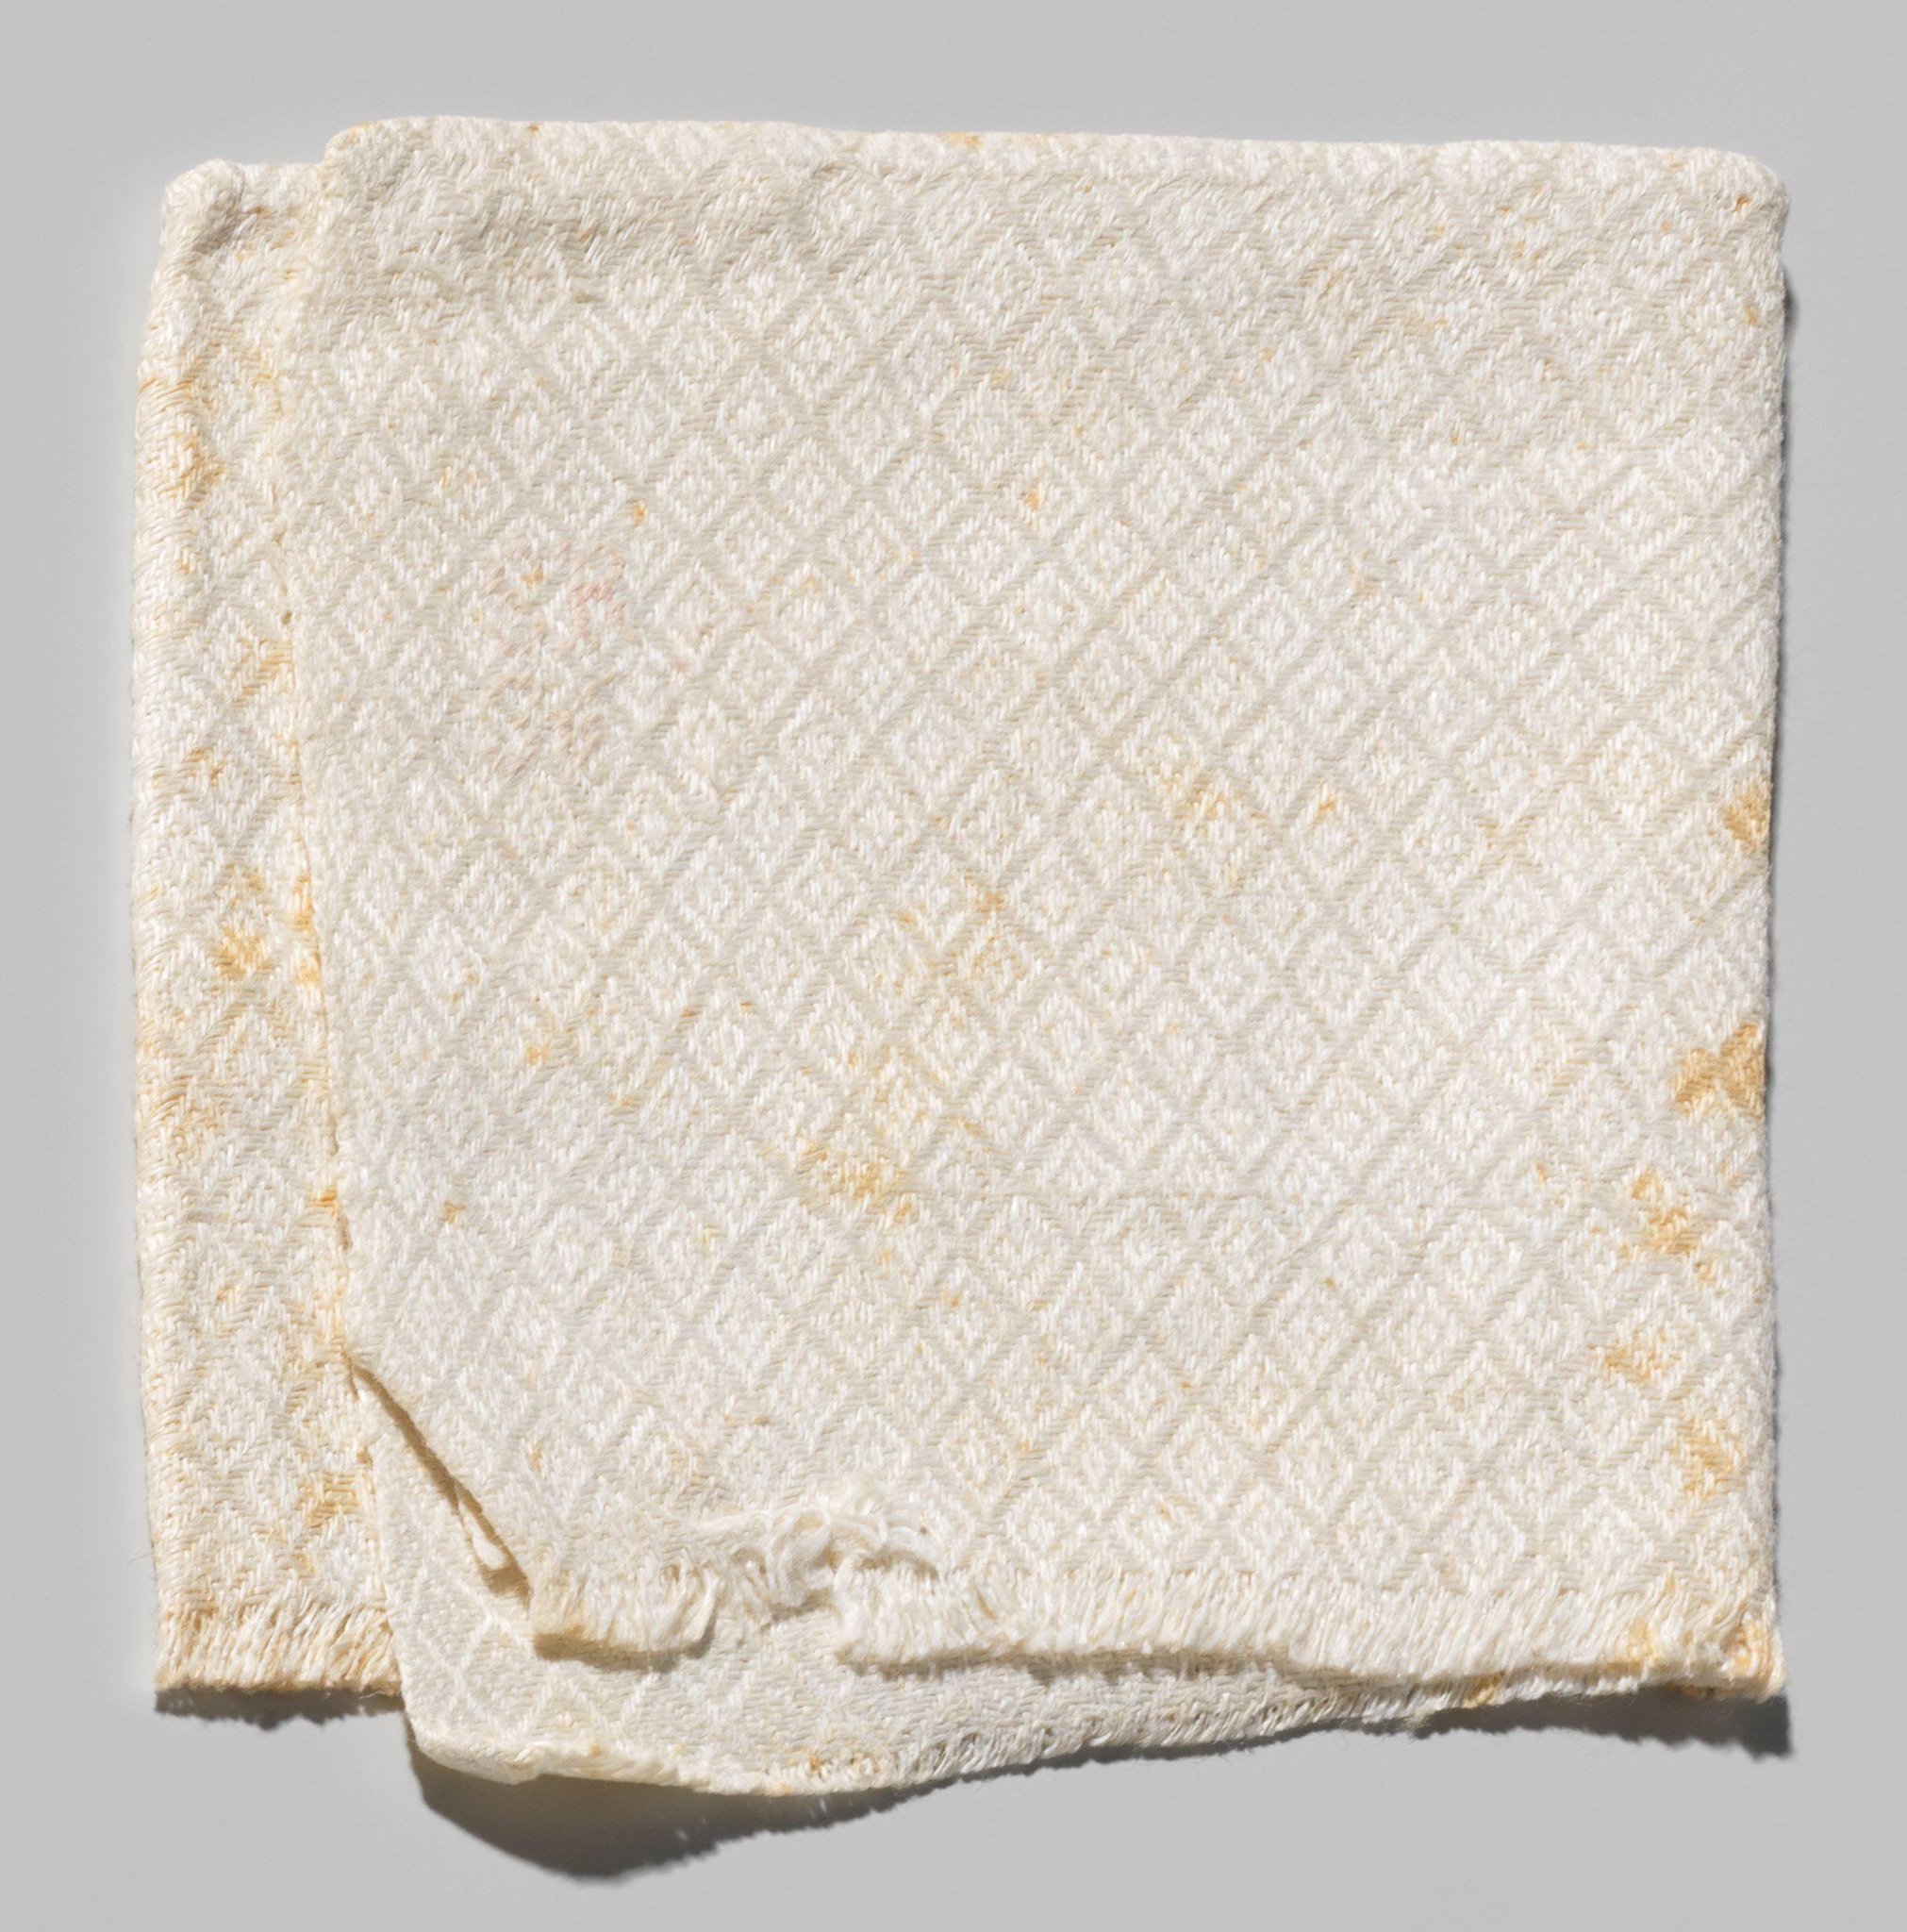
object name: napkin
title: Servet, fragment, met een patroon van ruitwerk met concentrische cirkels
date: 1600-1699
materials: linen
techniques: peeled fabric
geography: netherlands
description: Servet, fragment, van wit linnen met een patroon van ruitwerk met concentrische ruitvullingen.